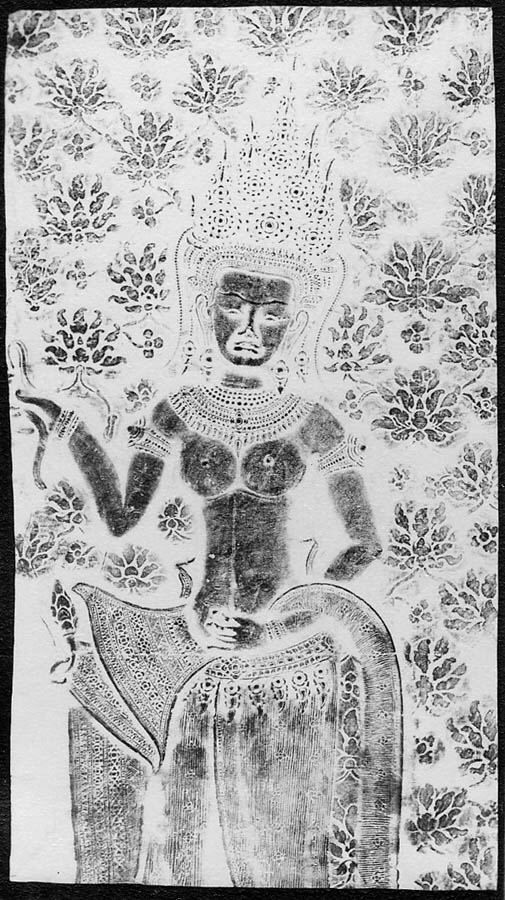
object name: rubbing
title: Rubbing of an Apsaras (Dancer)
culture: cambodian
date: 1901-2000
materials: ink, paper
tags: dancers